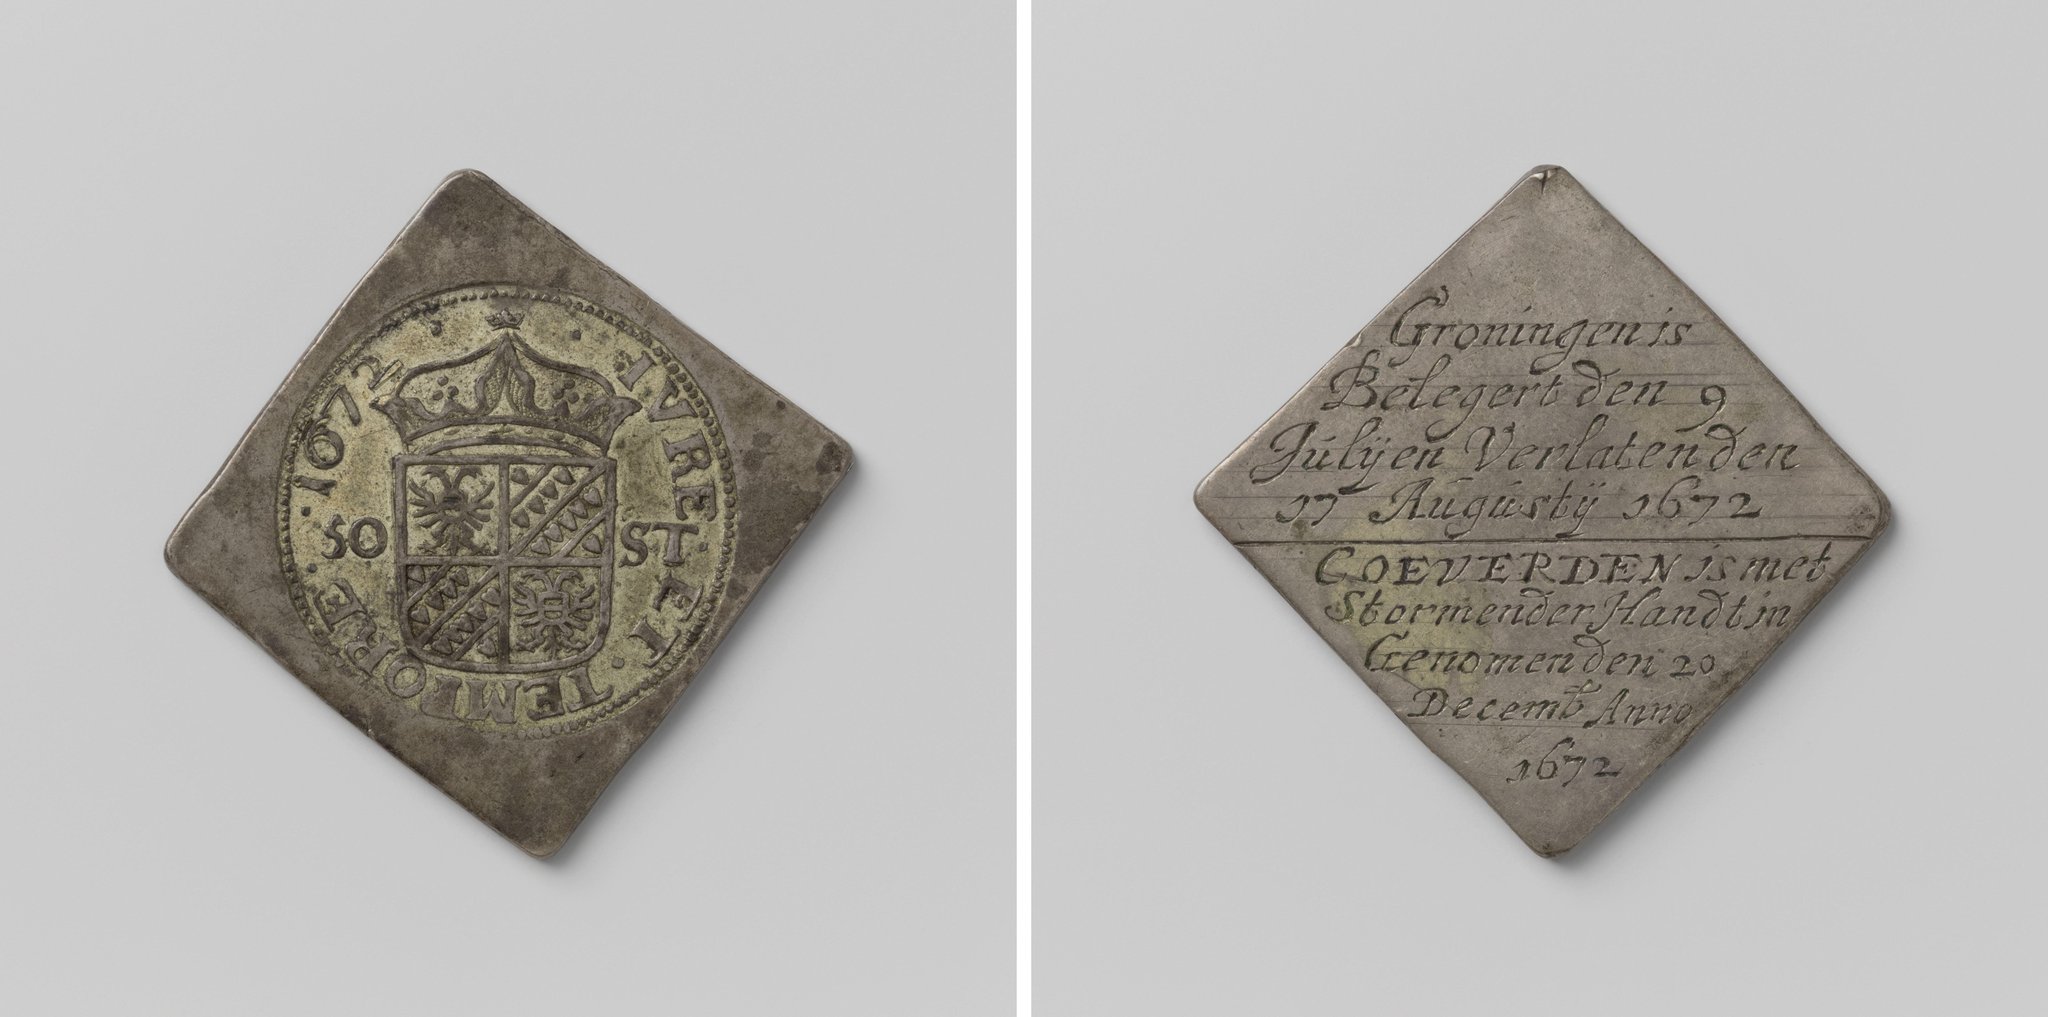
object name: thaler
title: Daalder, noodmunt uit Groningen, geslagen tijdens het beleg (voorzien van een gravering)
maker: Anonymous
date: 1672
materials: silver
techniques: engraving, striking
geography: groningen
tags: groningen, coevorden, beleg van groningen (1672), inname van coevorden (1672)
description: ruitvormige noodmunt uit Groningen, met afgeronde hoeken. Voorzijde: gekroond wapenschild (grote stempel) tussen waardeaanduiding binnen omschrift. Keerzijde: twee opschriften van elkaar gescheiden door horizontale lijn "Groningen is Belegert den 9 July en Verlaten den 17 Augusty 1672" en "Coevorden is met Stormender Handt in Genomen den 20 Decemb Anno 1672"